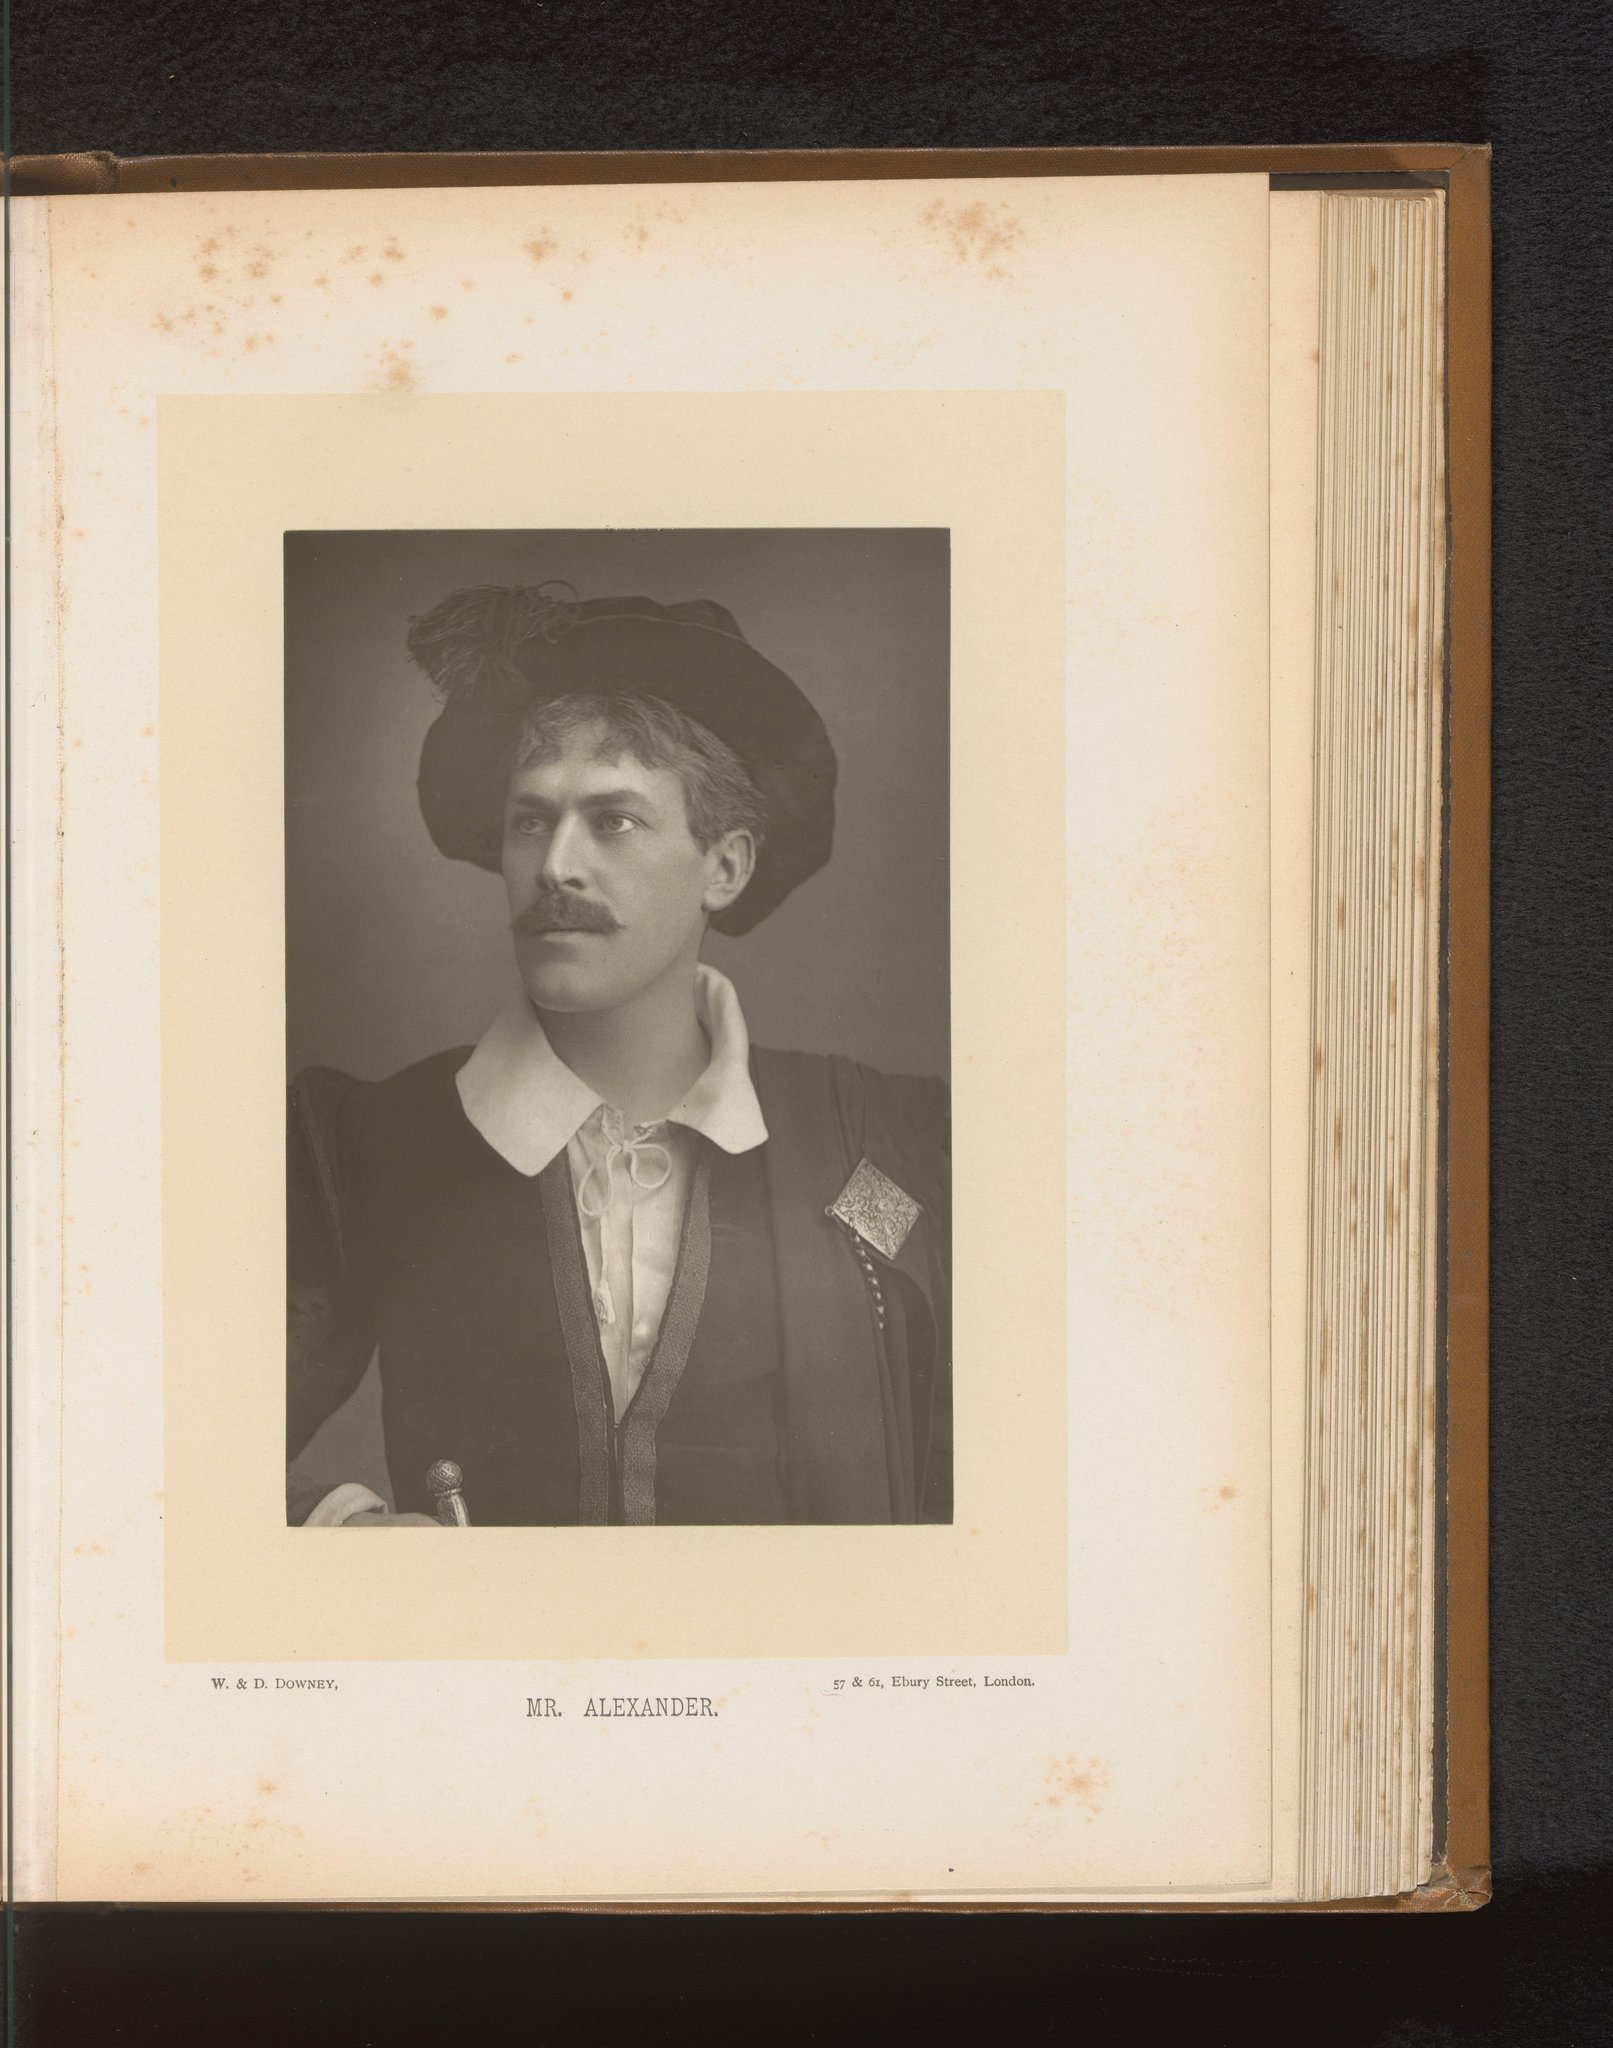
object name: page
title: Portret van George Alexander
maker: Anonymous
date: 1883-1893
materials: paper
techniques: woodburytype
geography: london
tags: portrait of actor, actress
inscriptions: inscription: ‘57 & 61, Elbury Street, London.’